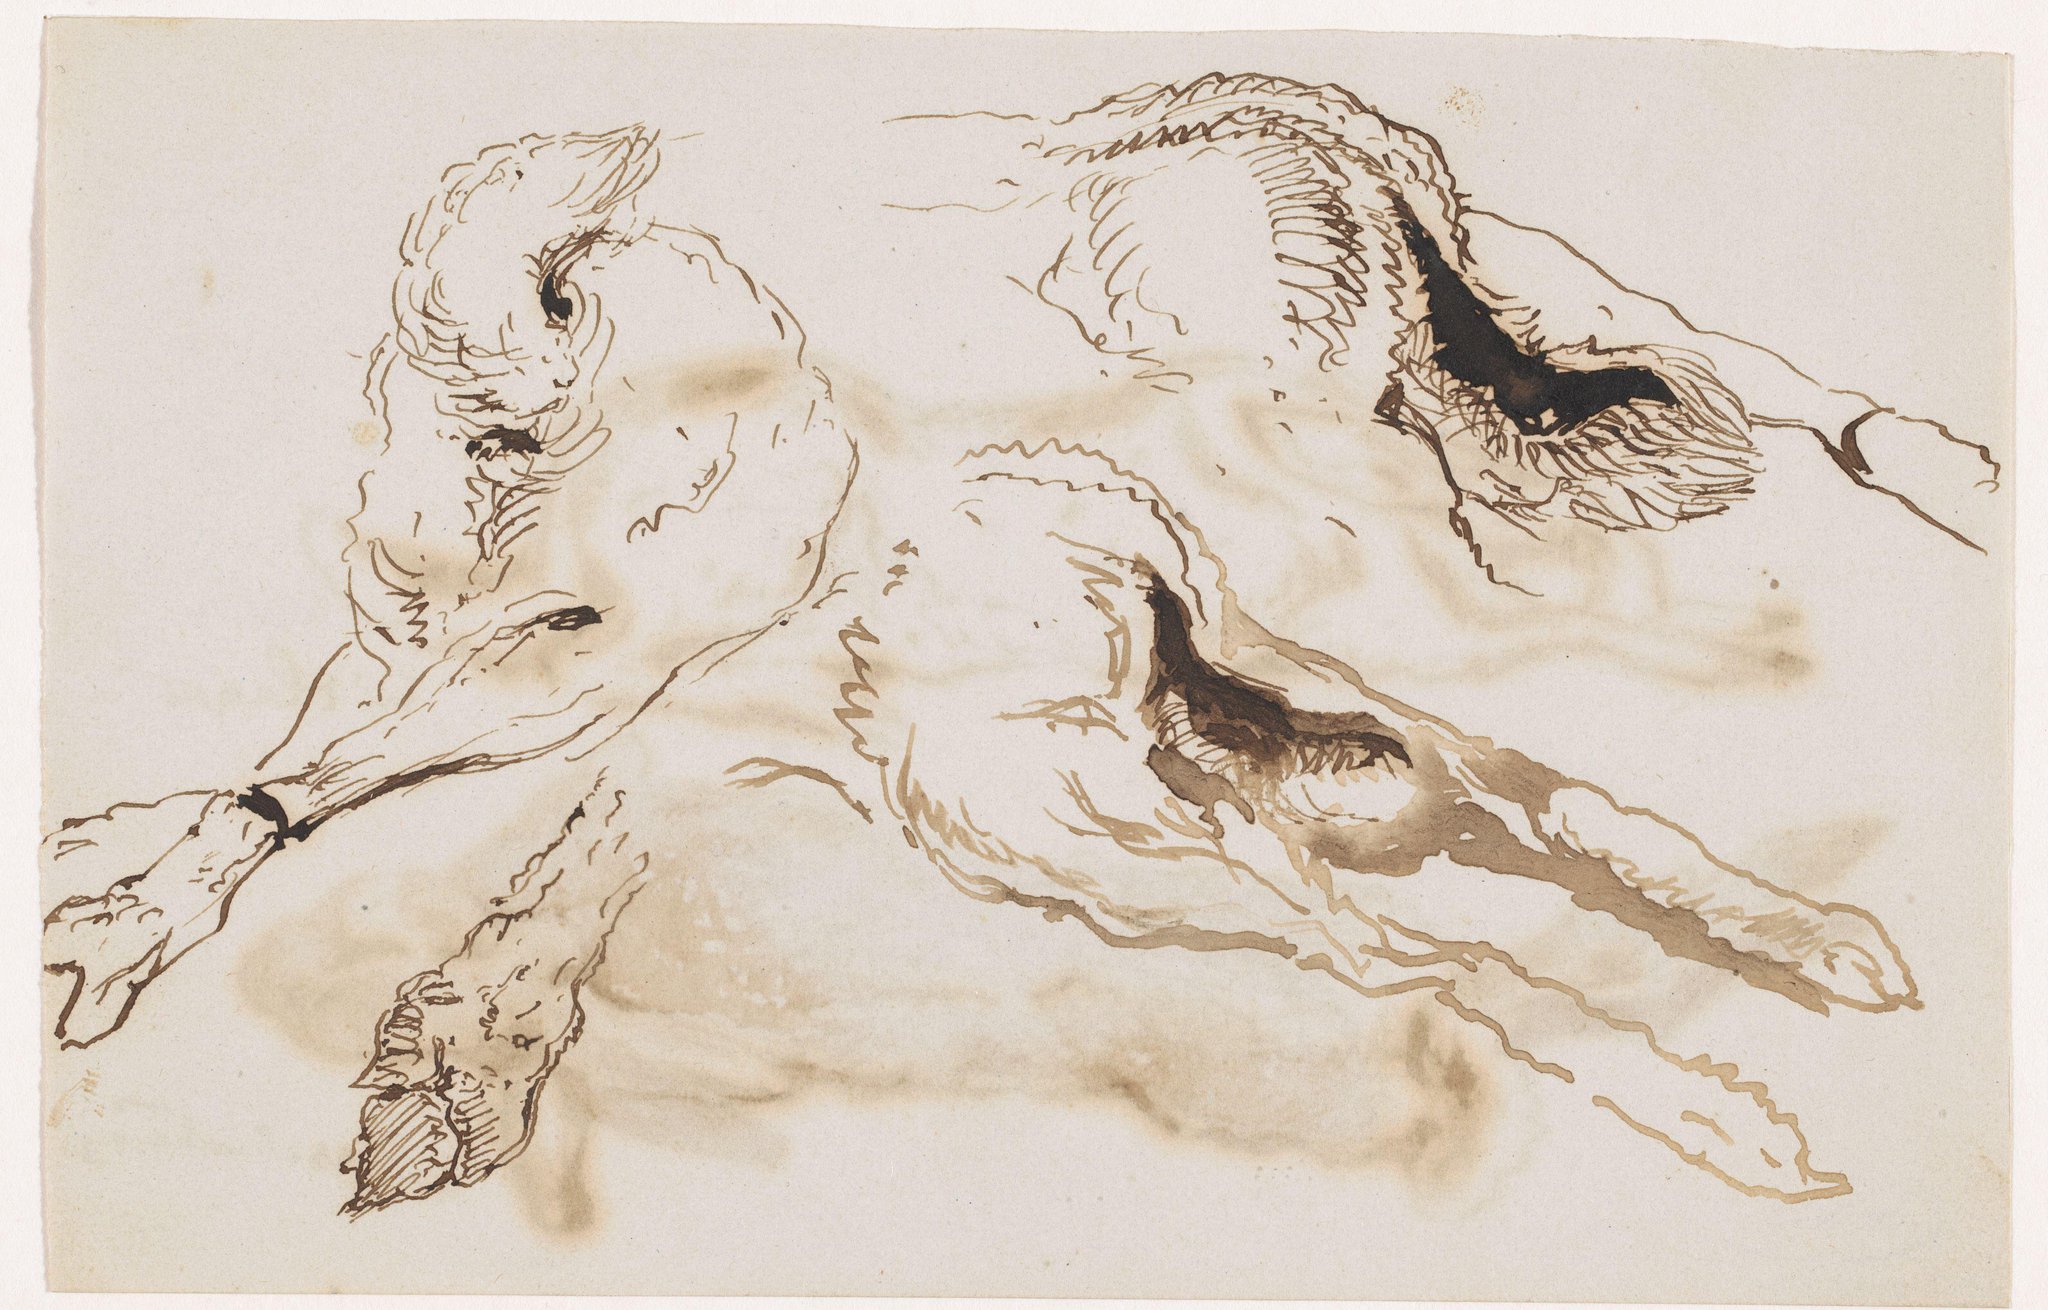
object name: drawing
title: Studies van de achterpoten van een dode haas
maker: johannes tavenraat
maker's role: draughtsman, painter, print maker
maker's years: 1809-1881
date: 1840-1880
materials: ink, paper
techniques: pen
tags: rodents (with name) (+ dying animal; death of animal; dead animal)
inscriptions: collector's mark: Lugt 2228